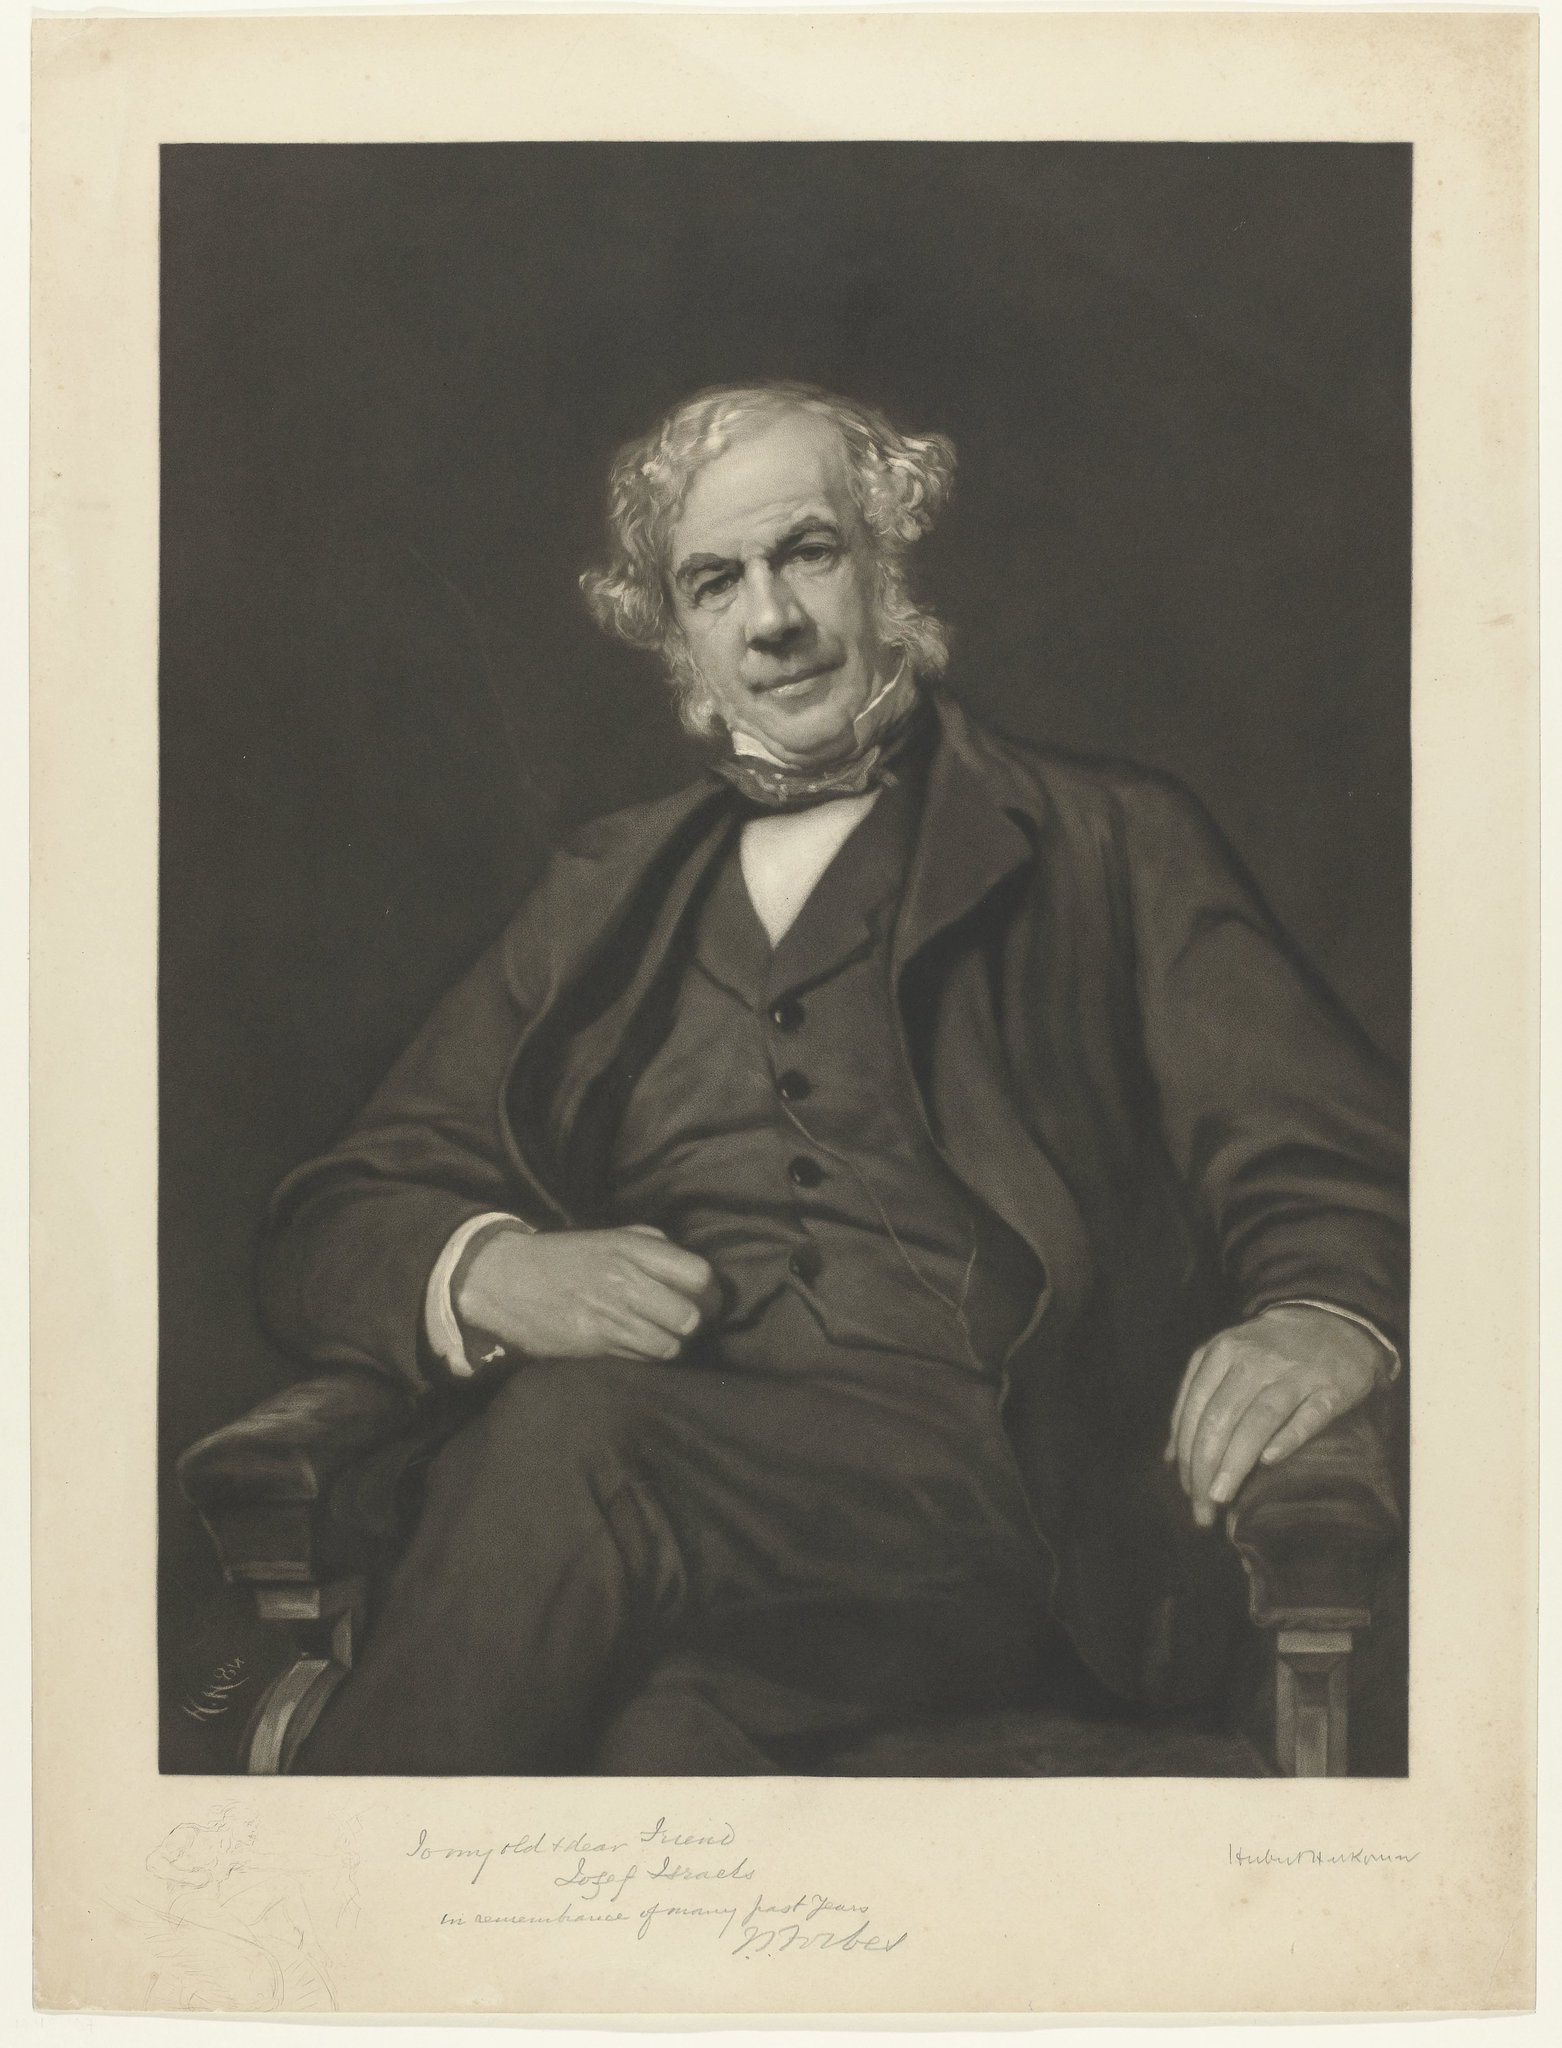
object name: print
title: Portret van James Staats Forbes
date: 1859-1914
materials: paper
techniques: drypoint, roulette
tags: james staats forbes, historical persons, art collector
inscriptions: : ‘To my old + dear friend/ Josef Israels In remembrance of many fast years, Hubert’, collector's mark: Lugt 2228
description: Linksonder een remarque met een schetsmatige voorstelling van mogelijk Apollo of Jupiter op een gevleugelde strijdwagen.